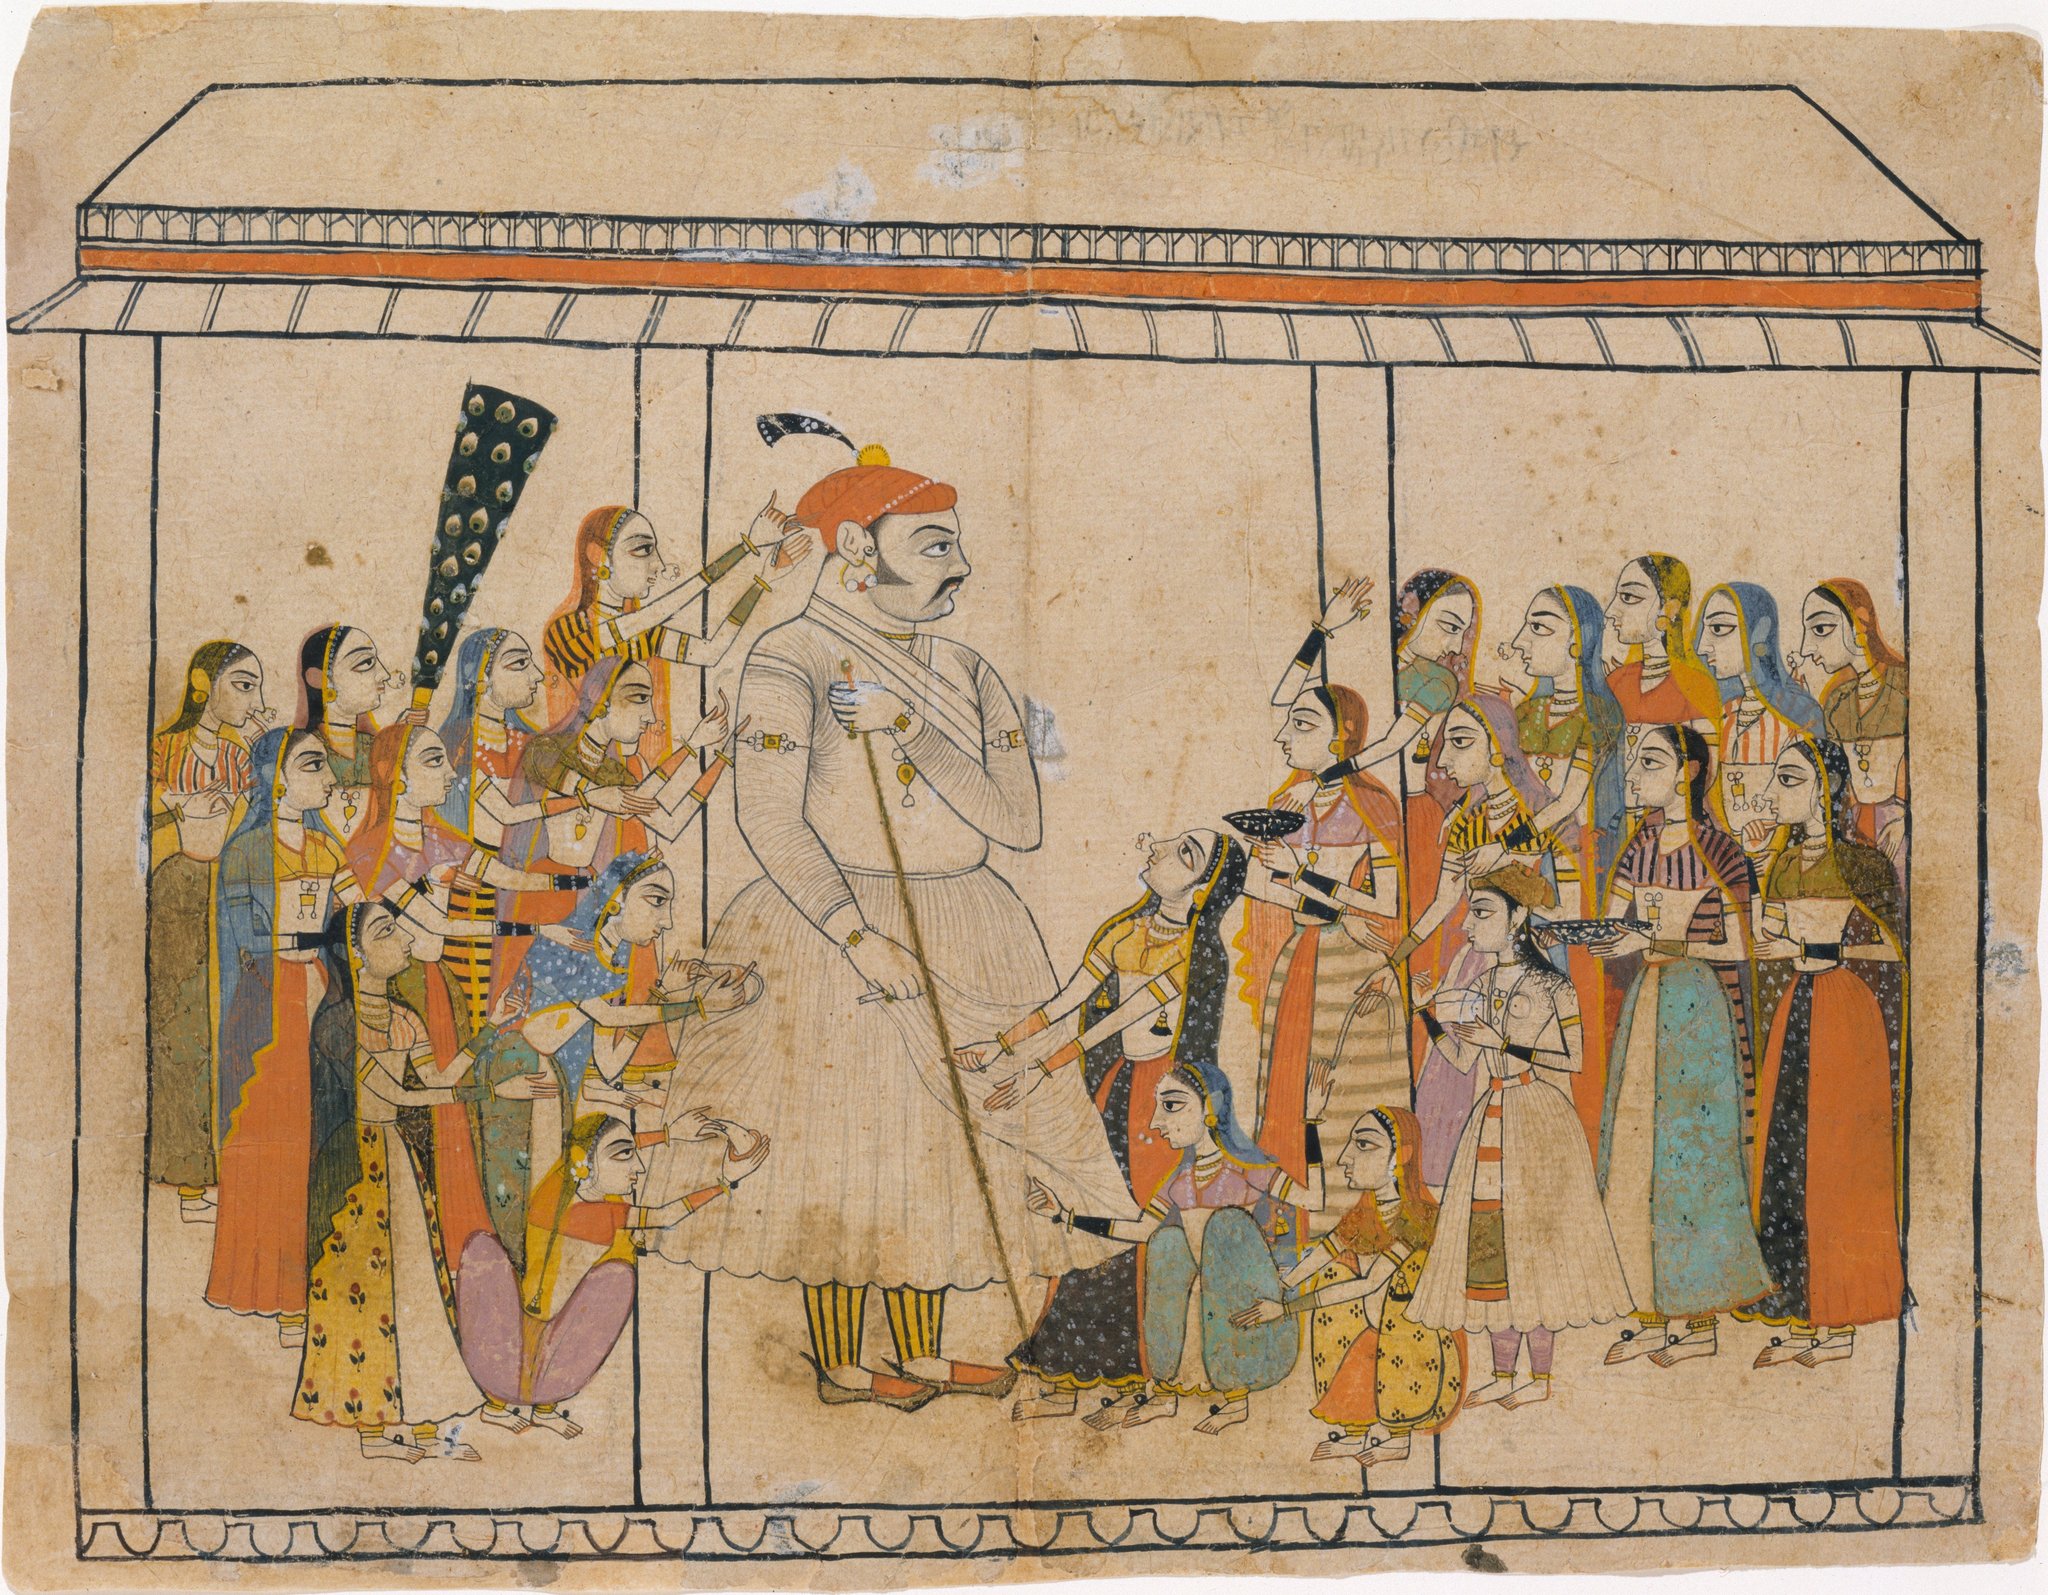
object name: painting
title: Maharaja Raj Singh Adored by His Ladies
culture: indian, rajasthani, sawar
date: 1710-1720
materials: ink, paper, watercolor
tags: men,women